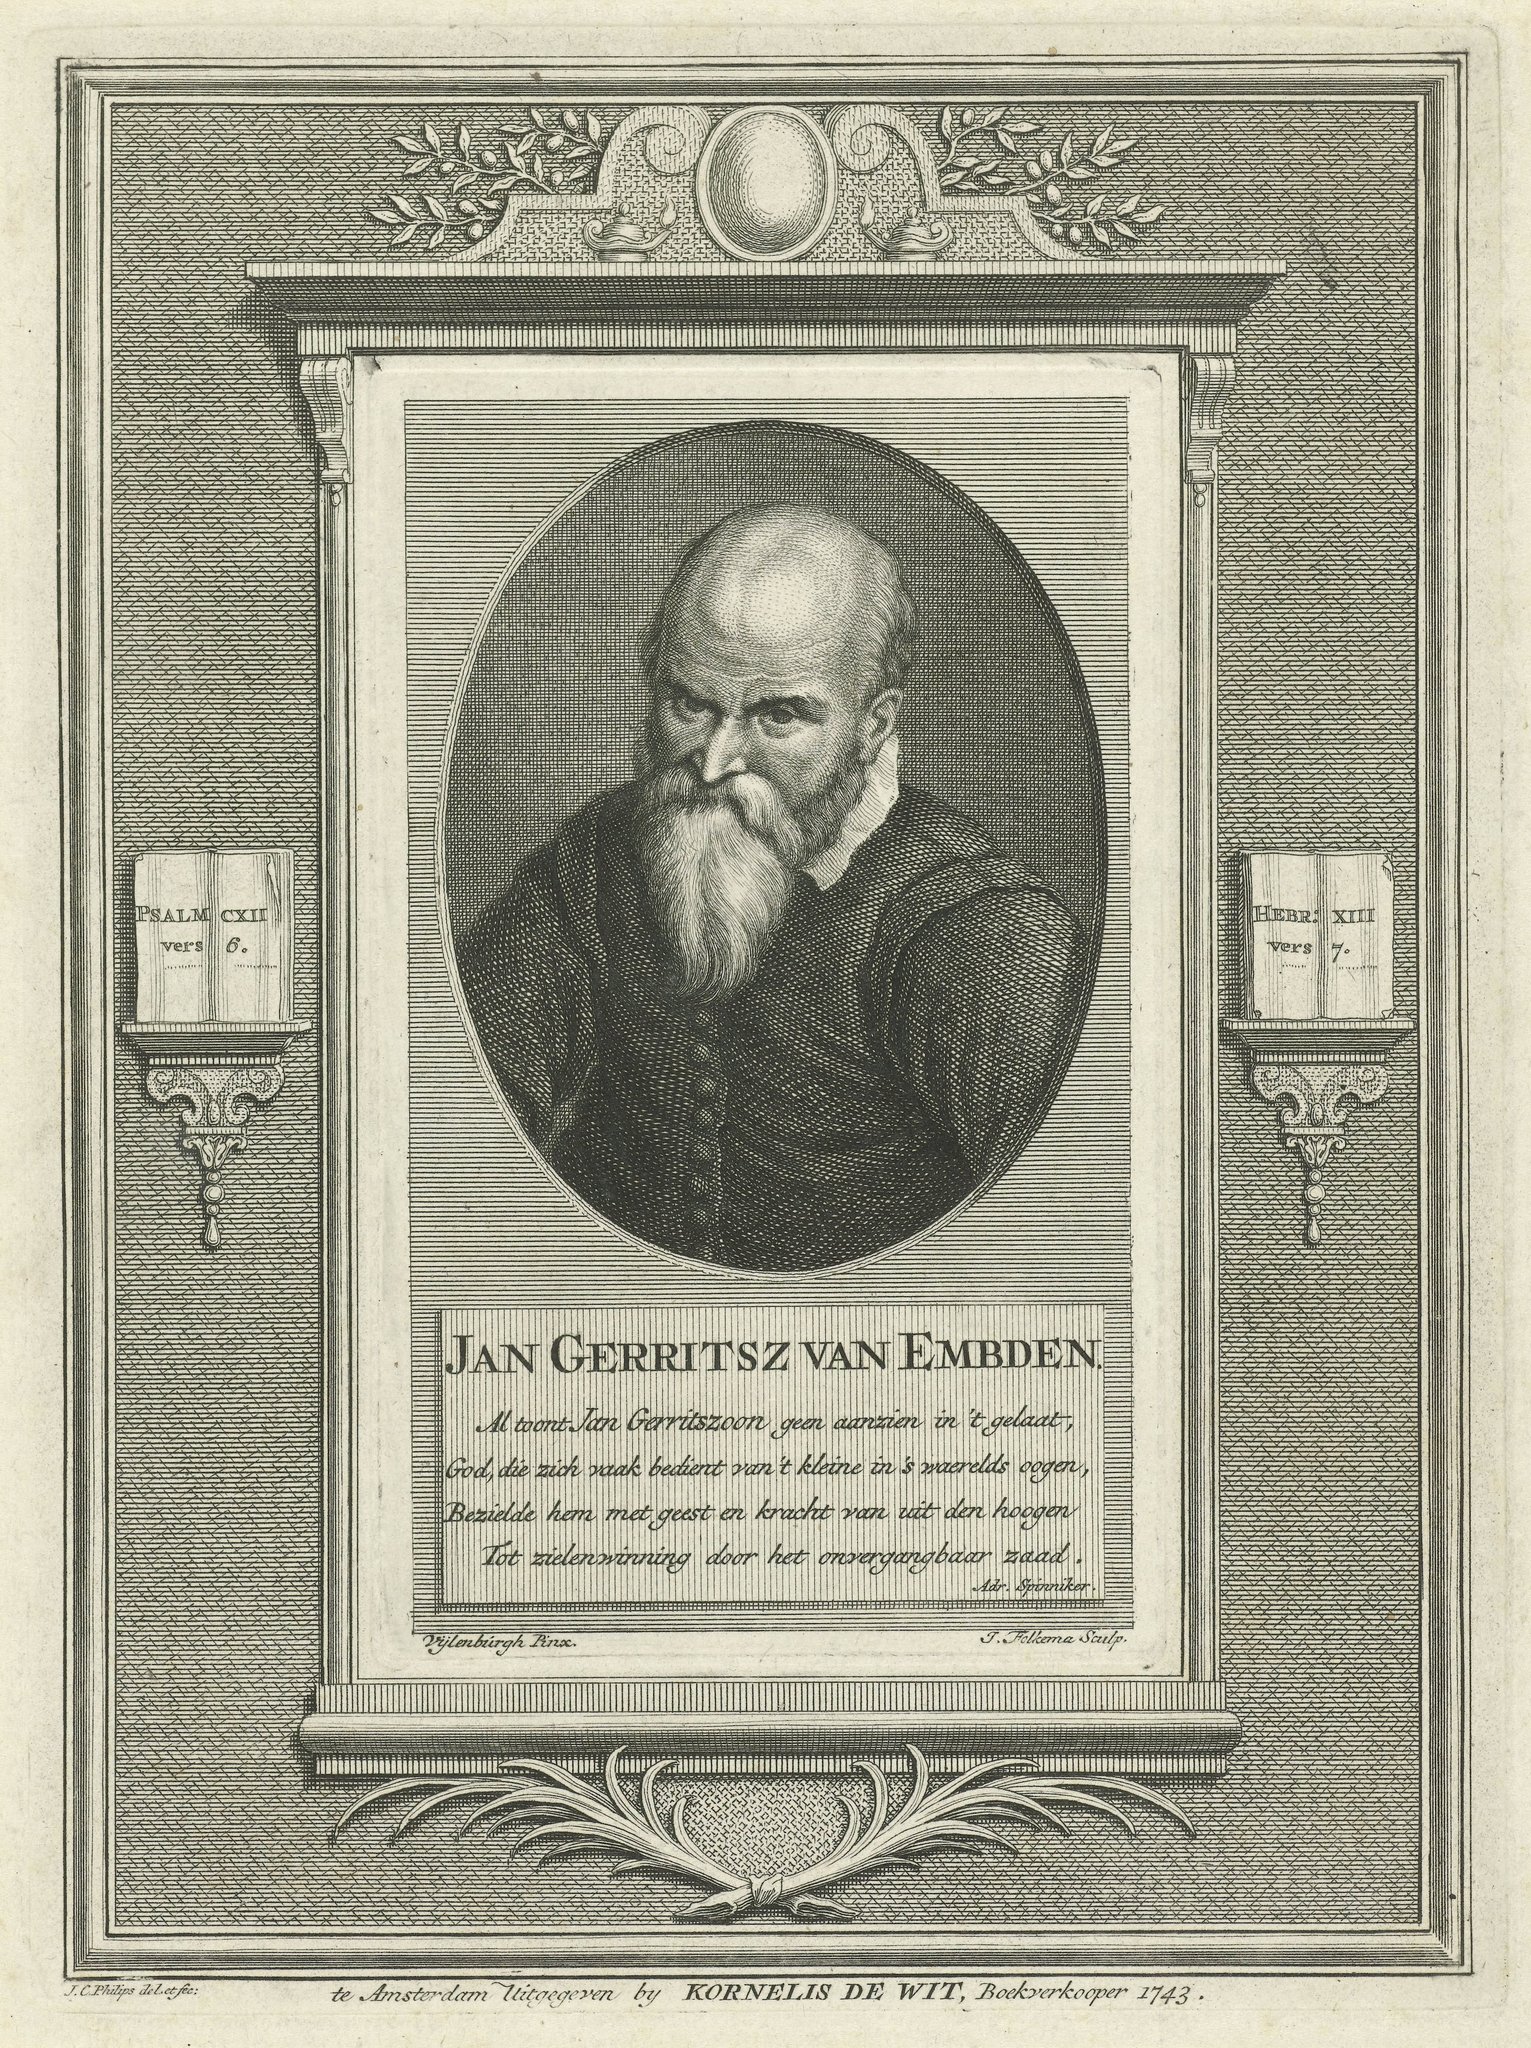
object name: print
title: Portret van Jan Gerrits van Embden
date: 1743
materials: paper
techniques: engraving, etching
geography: amsterdam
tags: predikant, jan gerrits van emden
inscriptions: collector's mark: Lugt 2228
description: Prent gedrukt van twee platen: Portretbuste in ovaal van predikant Jan Gerrits van Embden, blootshoofds. Onder het portret staan de naam van de geportretteerde en een vierregelig vers in het Nederlands. Het portret is omlijst met een ornamentele rand, gedrukt van een andere plaat, en versierd met palmbladeren en olijftakken. Links en rechts van het portret staan verwijzingen naar bijbelverzen.